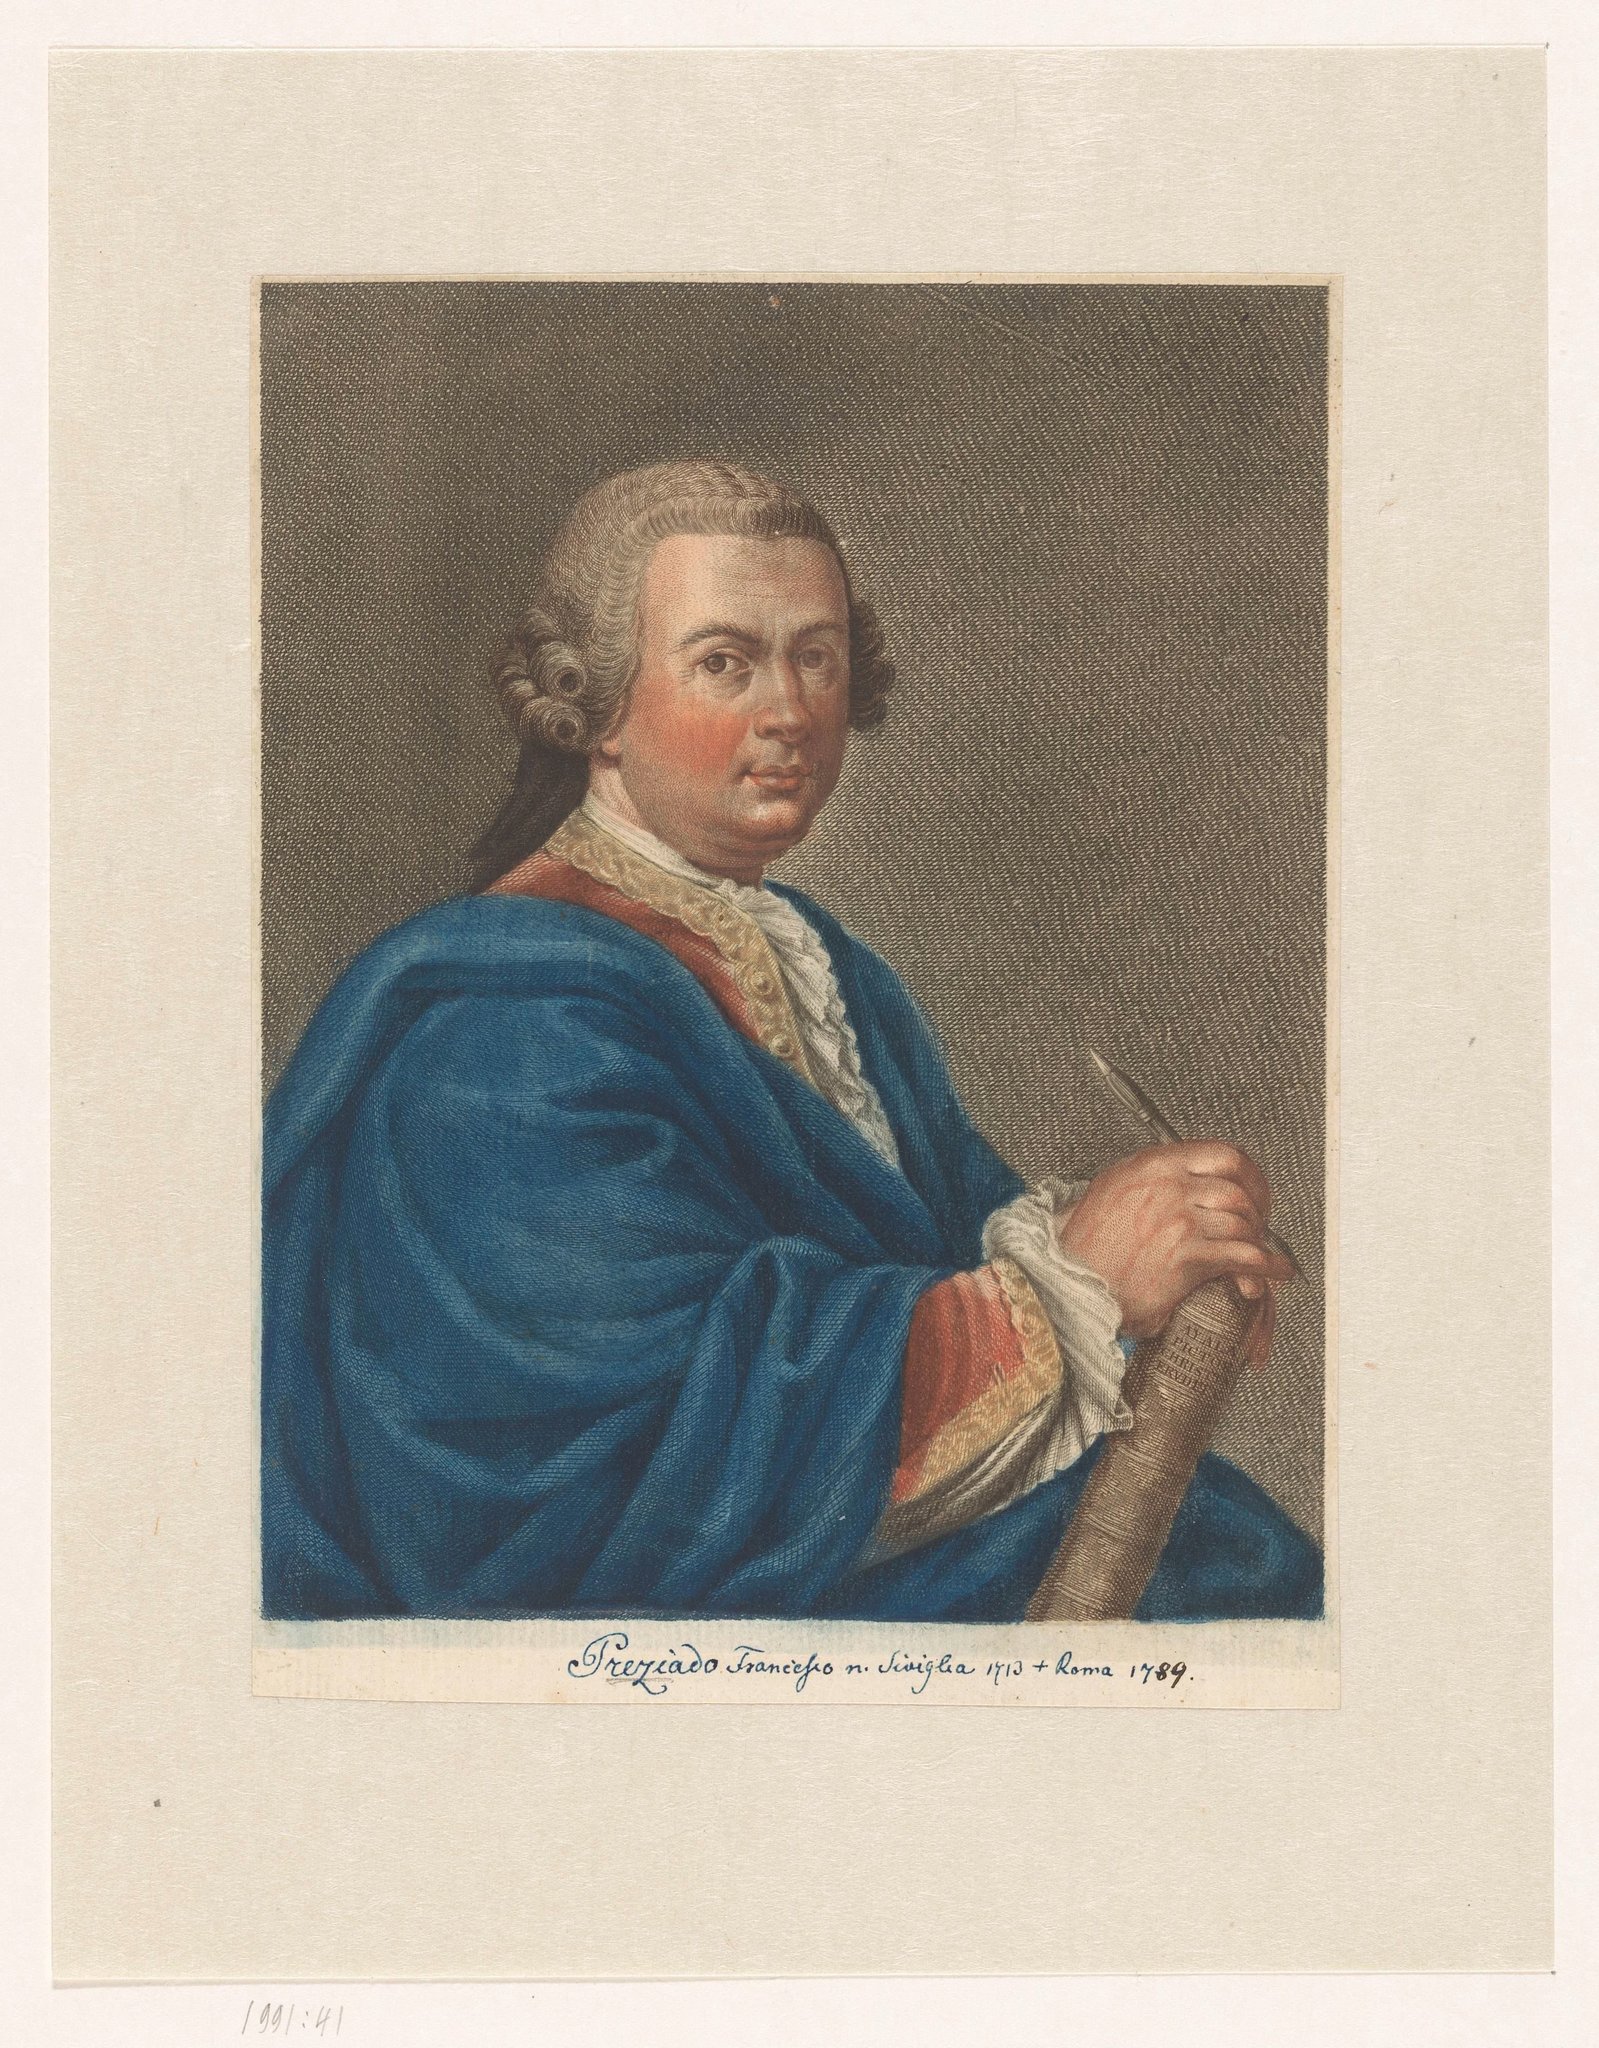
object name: book illustration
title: Portretten van kunstenaars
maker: antonio pazzi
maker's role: painter, print maker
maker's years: 1706-1768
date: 1752-1762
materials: paper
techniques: engraving, etching, hand coloring, lithography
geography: italy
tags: sevilla, rome, painter, francisco preciado de la vega, historical persons, portrait, self-portrait of artist, tools, implements of draughtsman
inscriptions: collector's mark: Lugt 2760, collector's mark: Lugt 2228, inscription: ‘Preziado Francisco n. Siviglia 1713 + Roma 17[...]’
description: Prent naar geschilderd zelfportret van Francisco Preciado de la Vega in de Galleria degli Uffizi te Florence (inv.nr. 2012). Prent uit: Moücke, Francesco. Serie di ritratti degli eccellenti pittori dipinti di propria mano, che esistono nell'Imiperial Galleria di Firenze. Florence: 1752-1762.